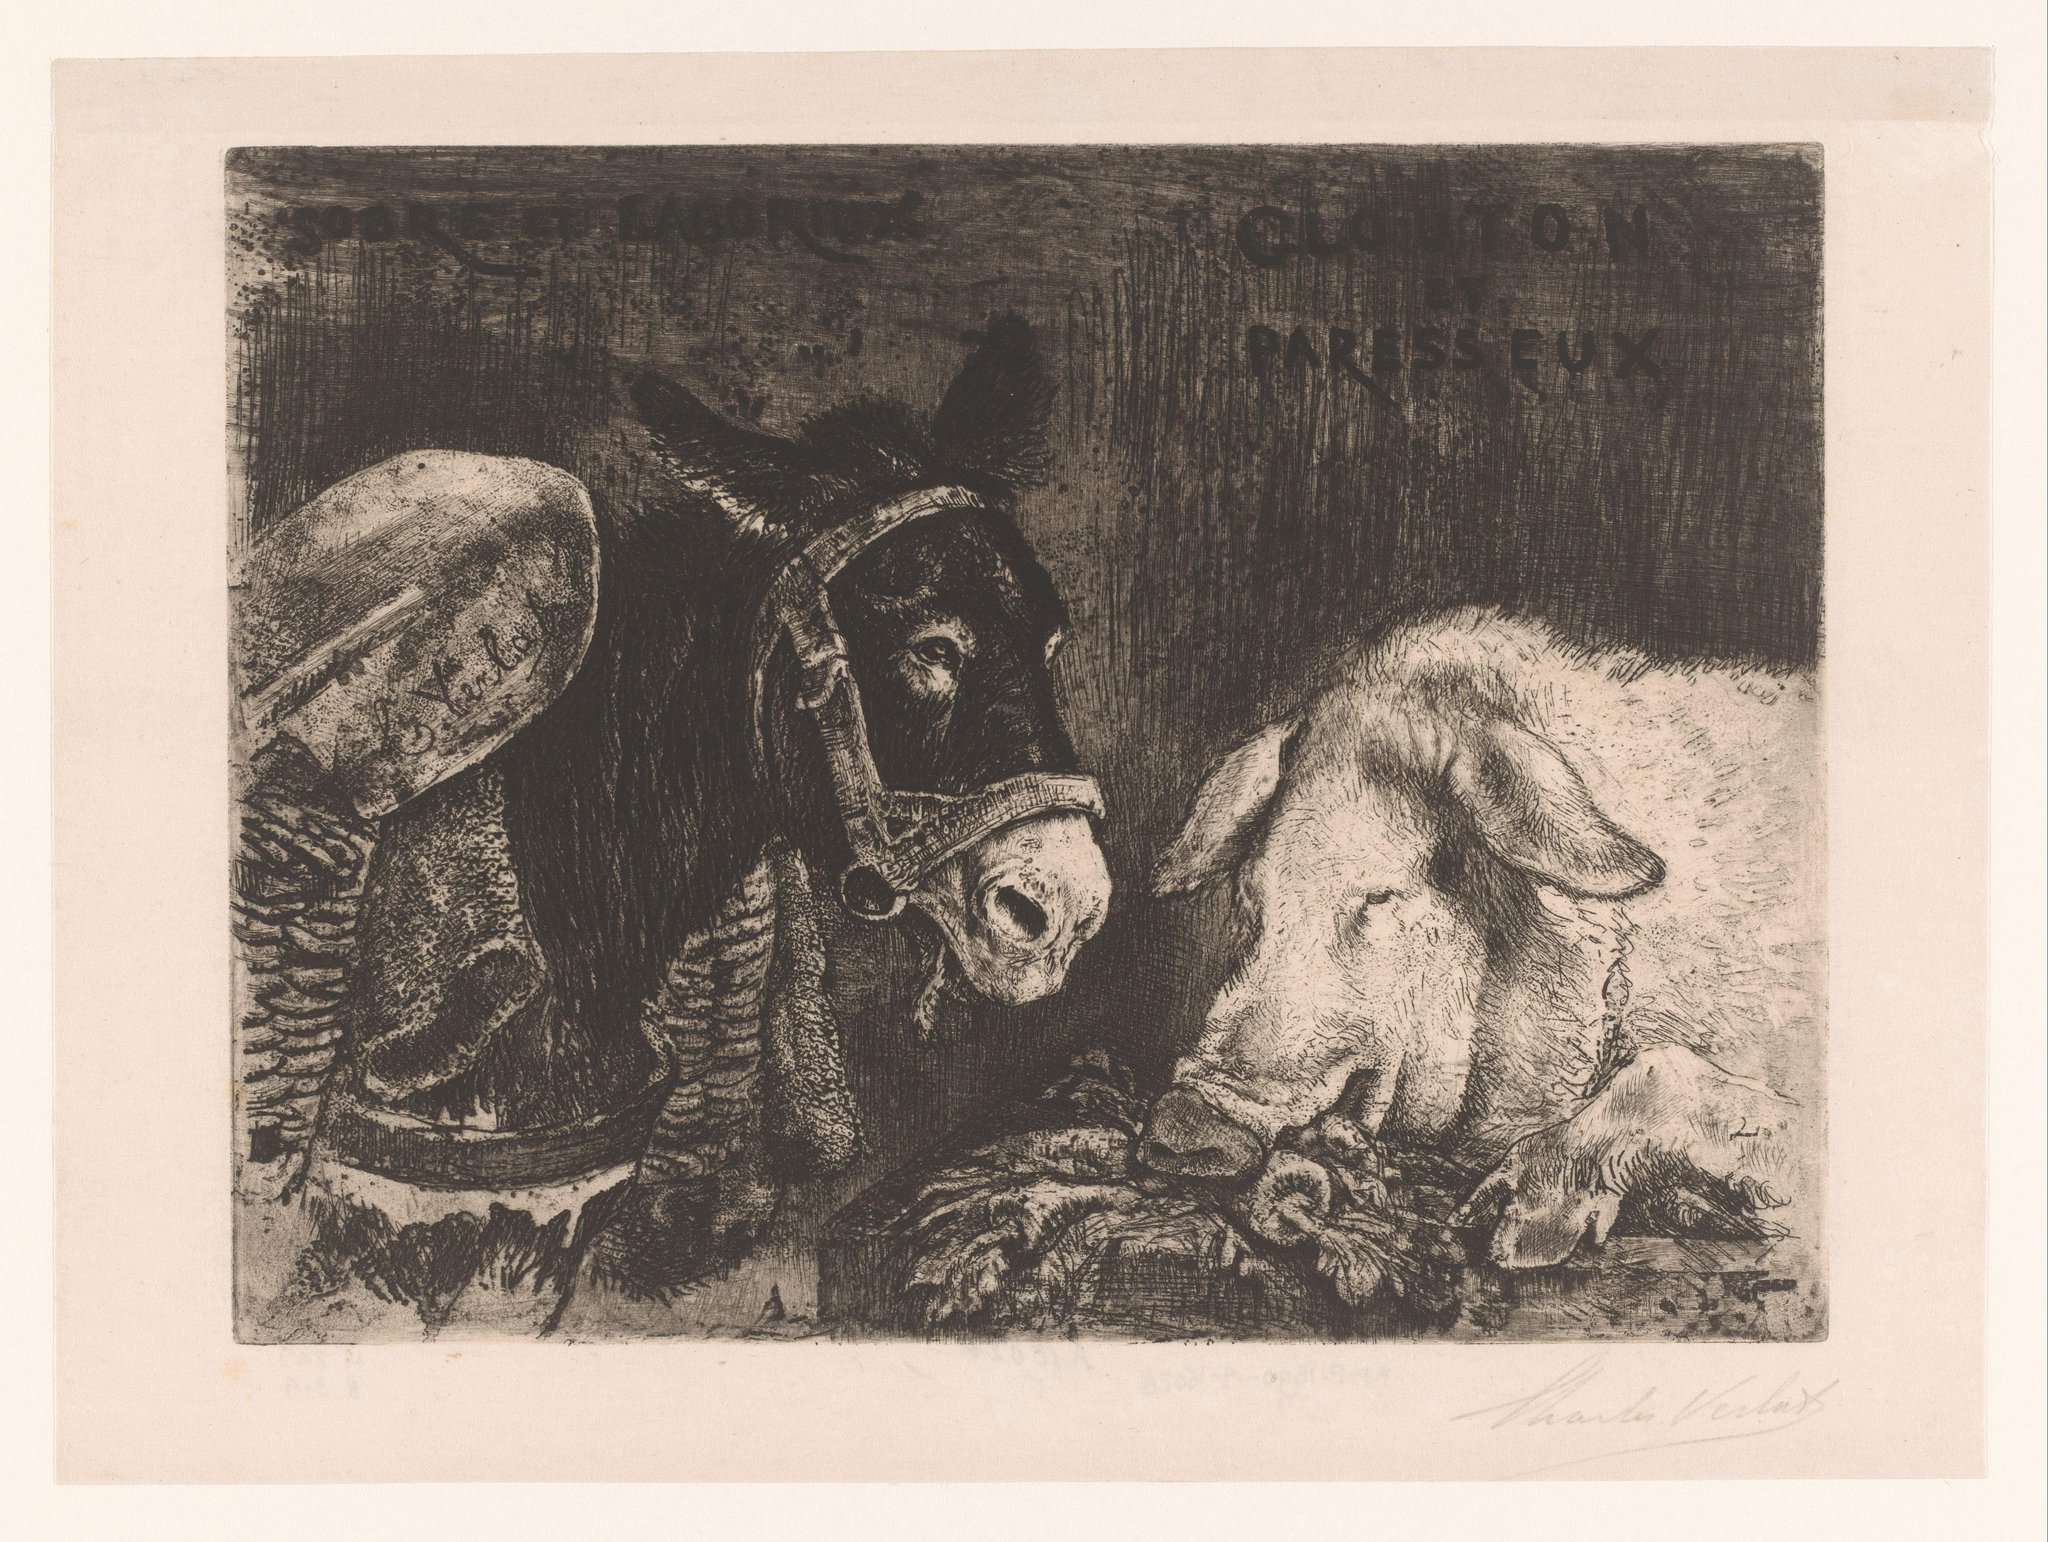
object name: print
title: Sobre et laborieux, Glouton et paresseux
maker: charles verlat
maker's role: painter, print maker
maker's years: 1824-1890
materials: paper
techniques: drypoint, etching, intaglio, retroussage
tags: pig, ass, donkey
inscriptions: collector's mark: Lugt 2228, workshop stamp: ‘Antwerpsche Etsers 1880’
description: Een pakezel en een etend zwijn, waarbij de tekst boven de dieren hen respectievelijk sober en hardwerkend, en gulzig en lui noemt.